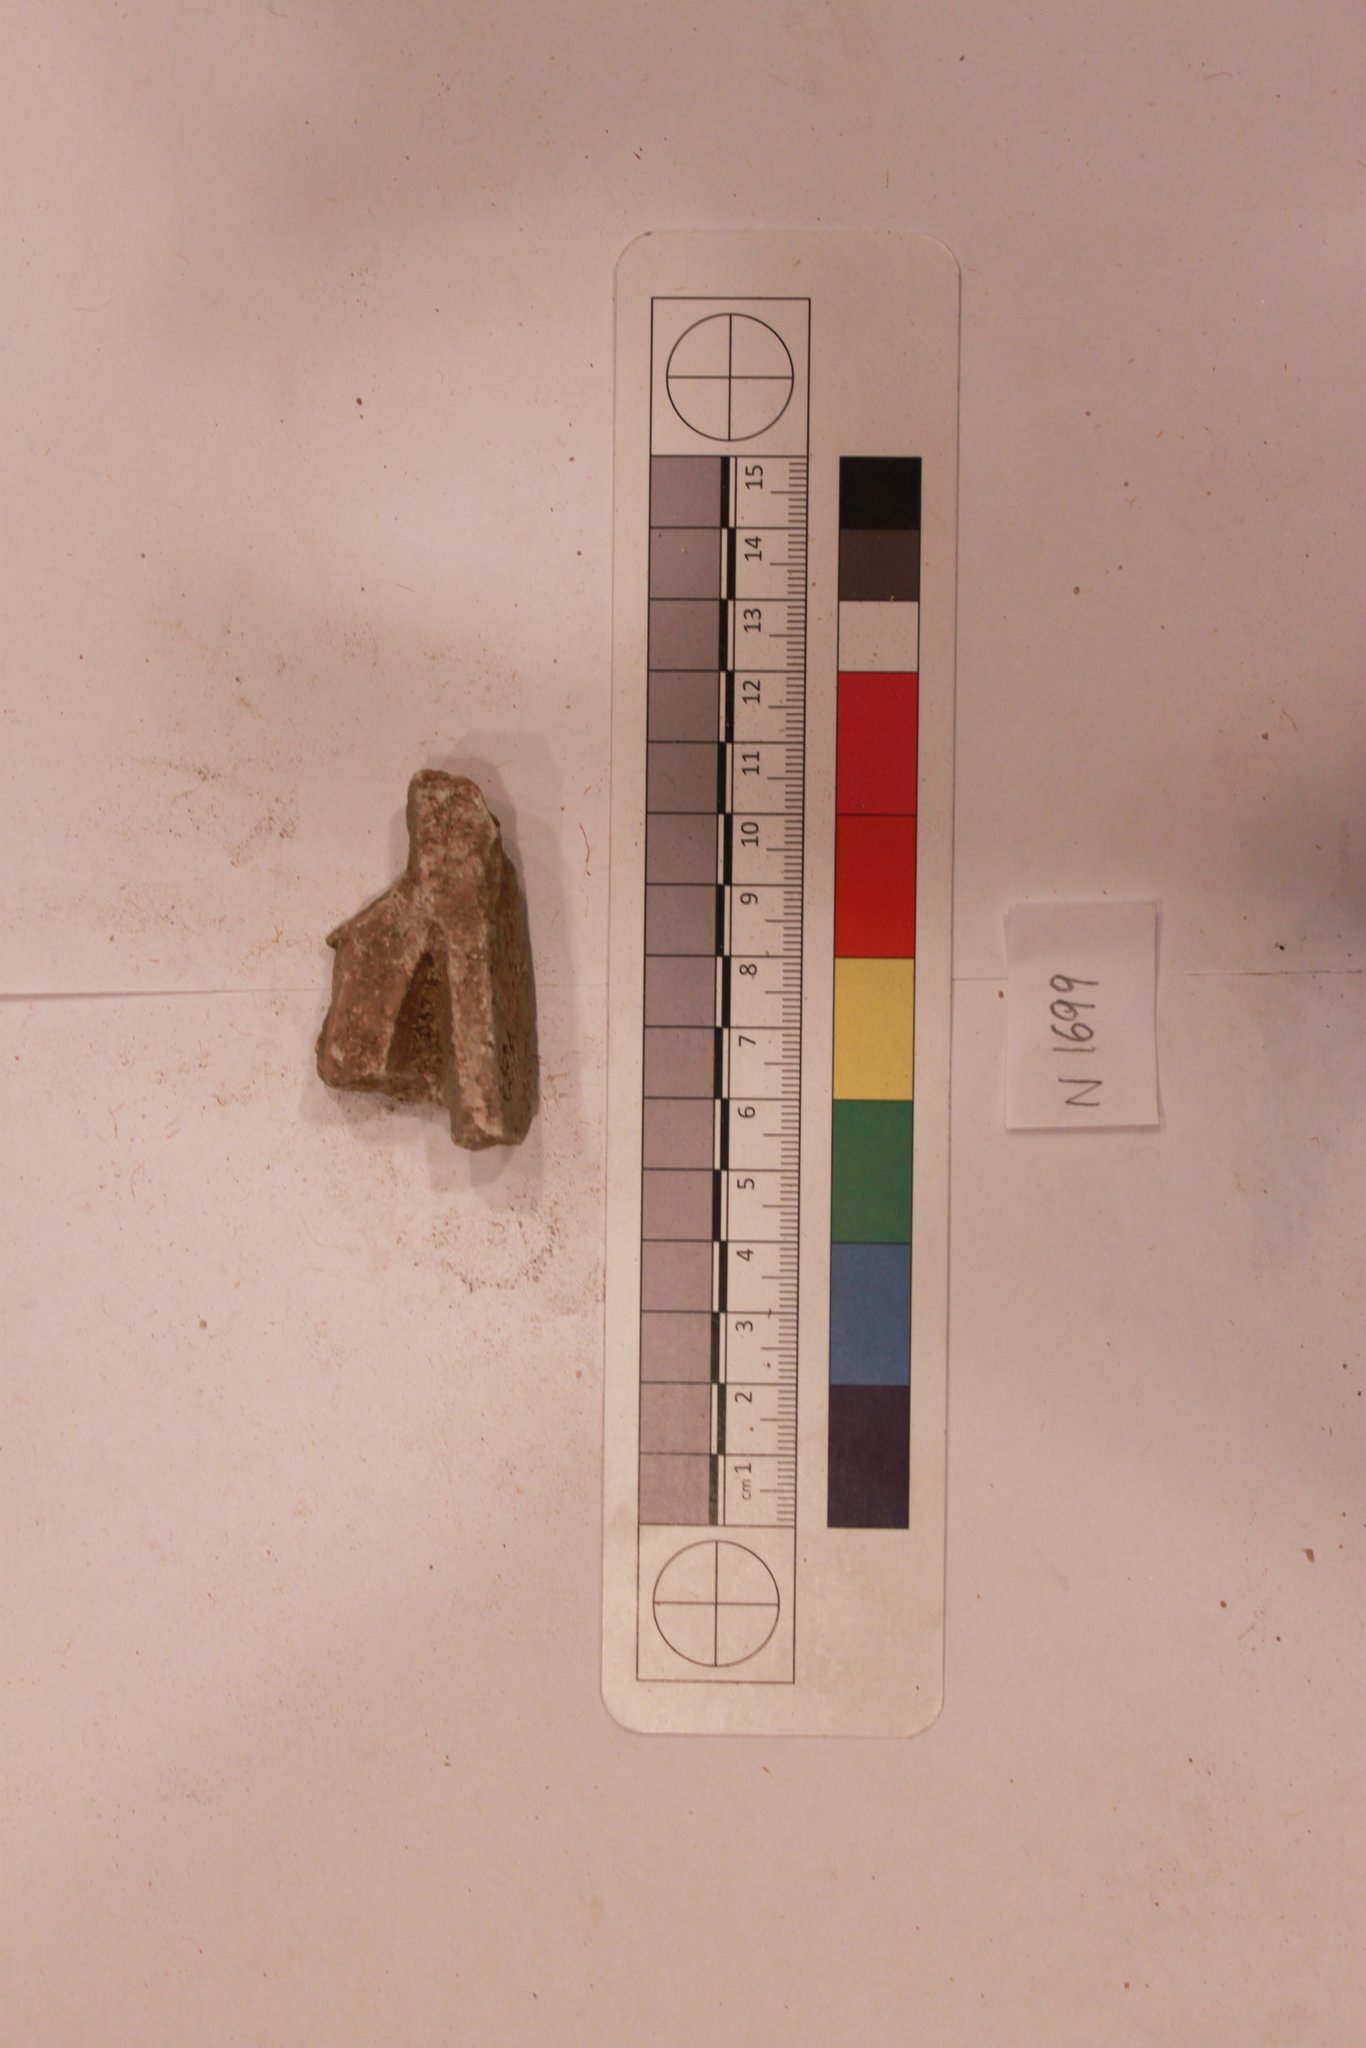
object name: fragment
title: Stucco Fragment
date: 701-1200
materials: plaster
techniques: carving, painting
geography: iran